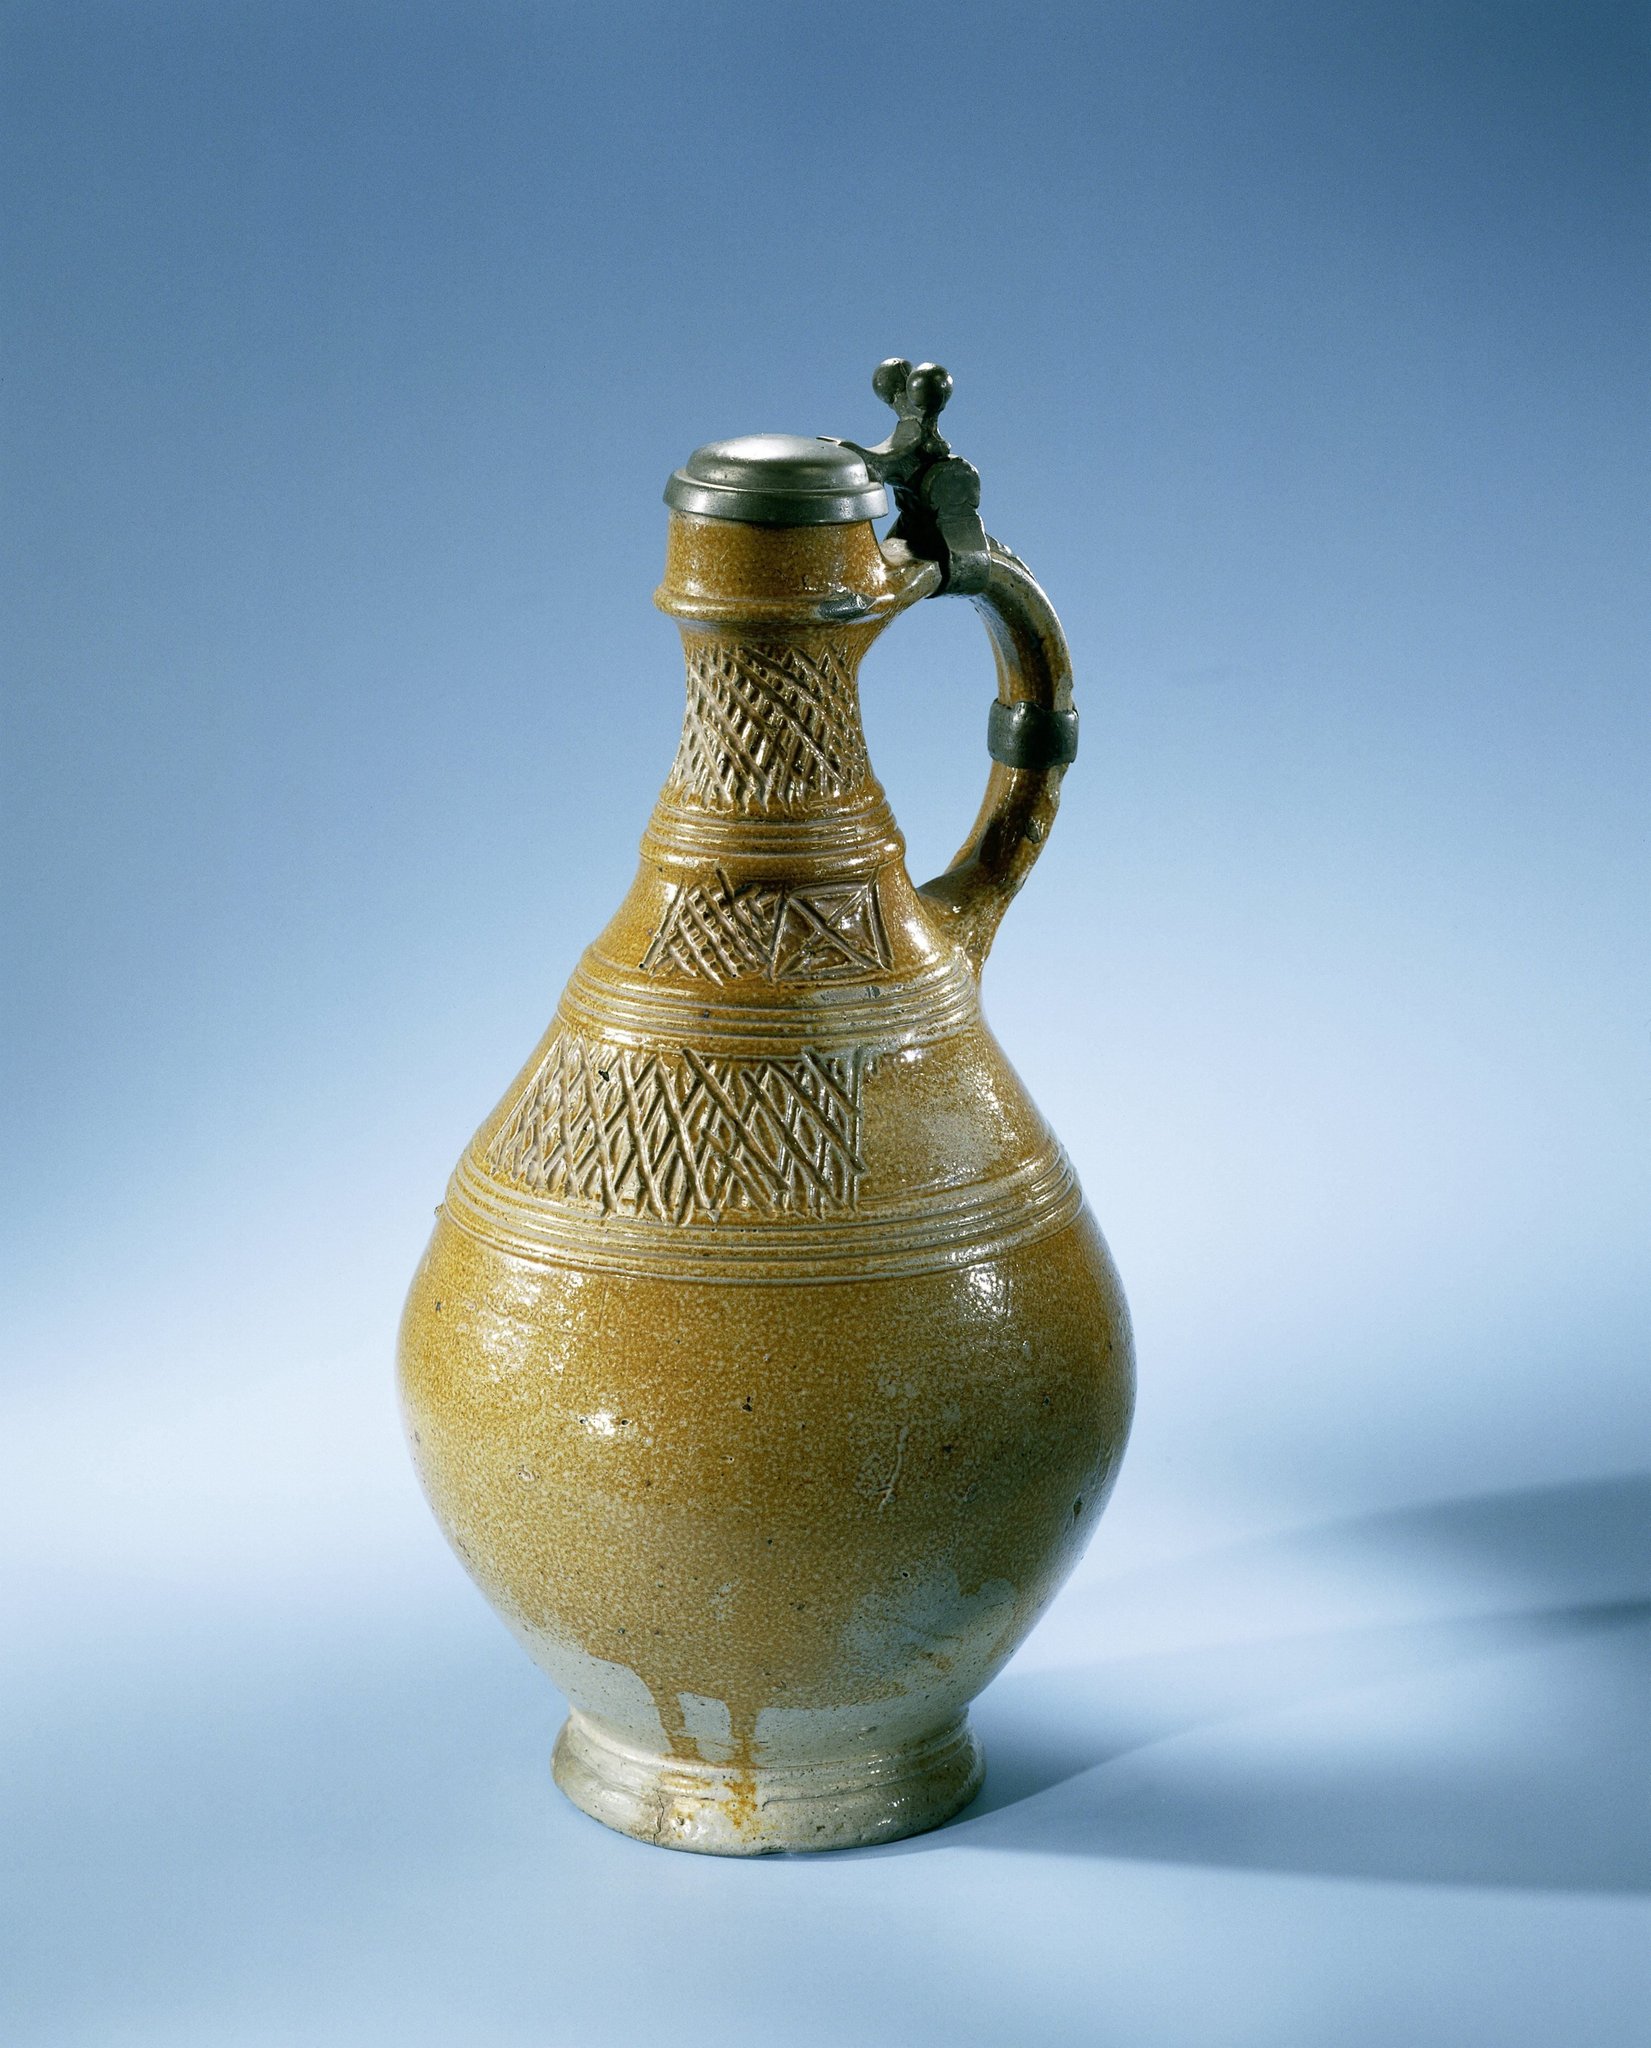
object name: jug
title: Jug with an incised decoration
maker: Anonymous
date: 1580-1600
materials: engobe, glaze, stoneware, tin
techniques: firing, forming, turning, vitrification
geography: raeren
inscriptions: mark: ‘I.T’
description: Kruik van steengoed op standring met een peervormig lichaam en smalle nek. Het C-vormige oor is bevestigd aan de nek en de schouder. Bedekt met een bruine engobe. Op de schouder en nek drie banden, gescheiden door profielen, met een ingegrifte decoratie die doet denken aan kerfsnede. Bevestigd aan het oor een tinnen montuur met deksel. Aan de binnenzijde gemerkt met een kroon en de letters 'I.T.'. Raeren.